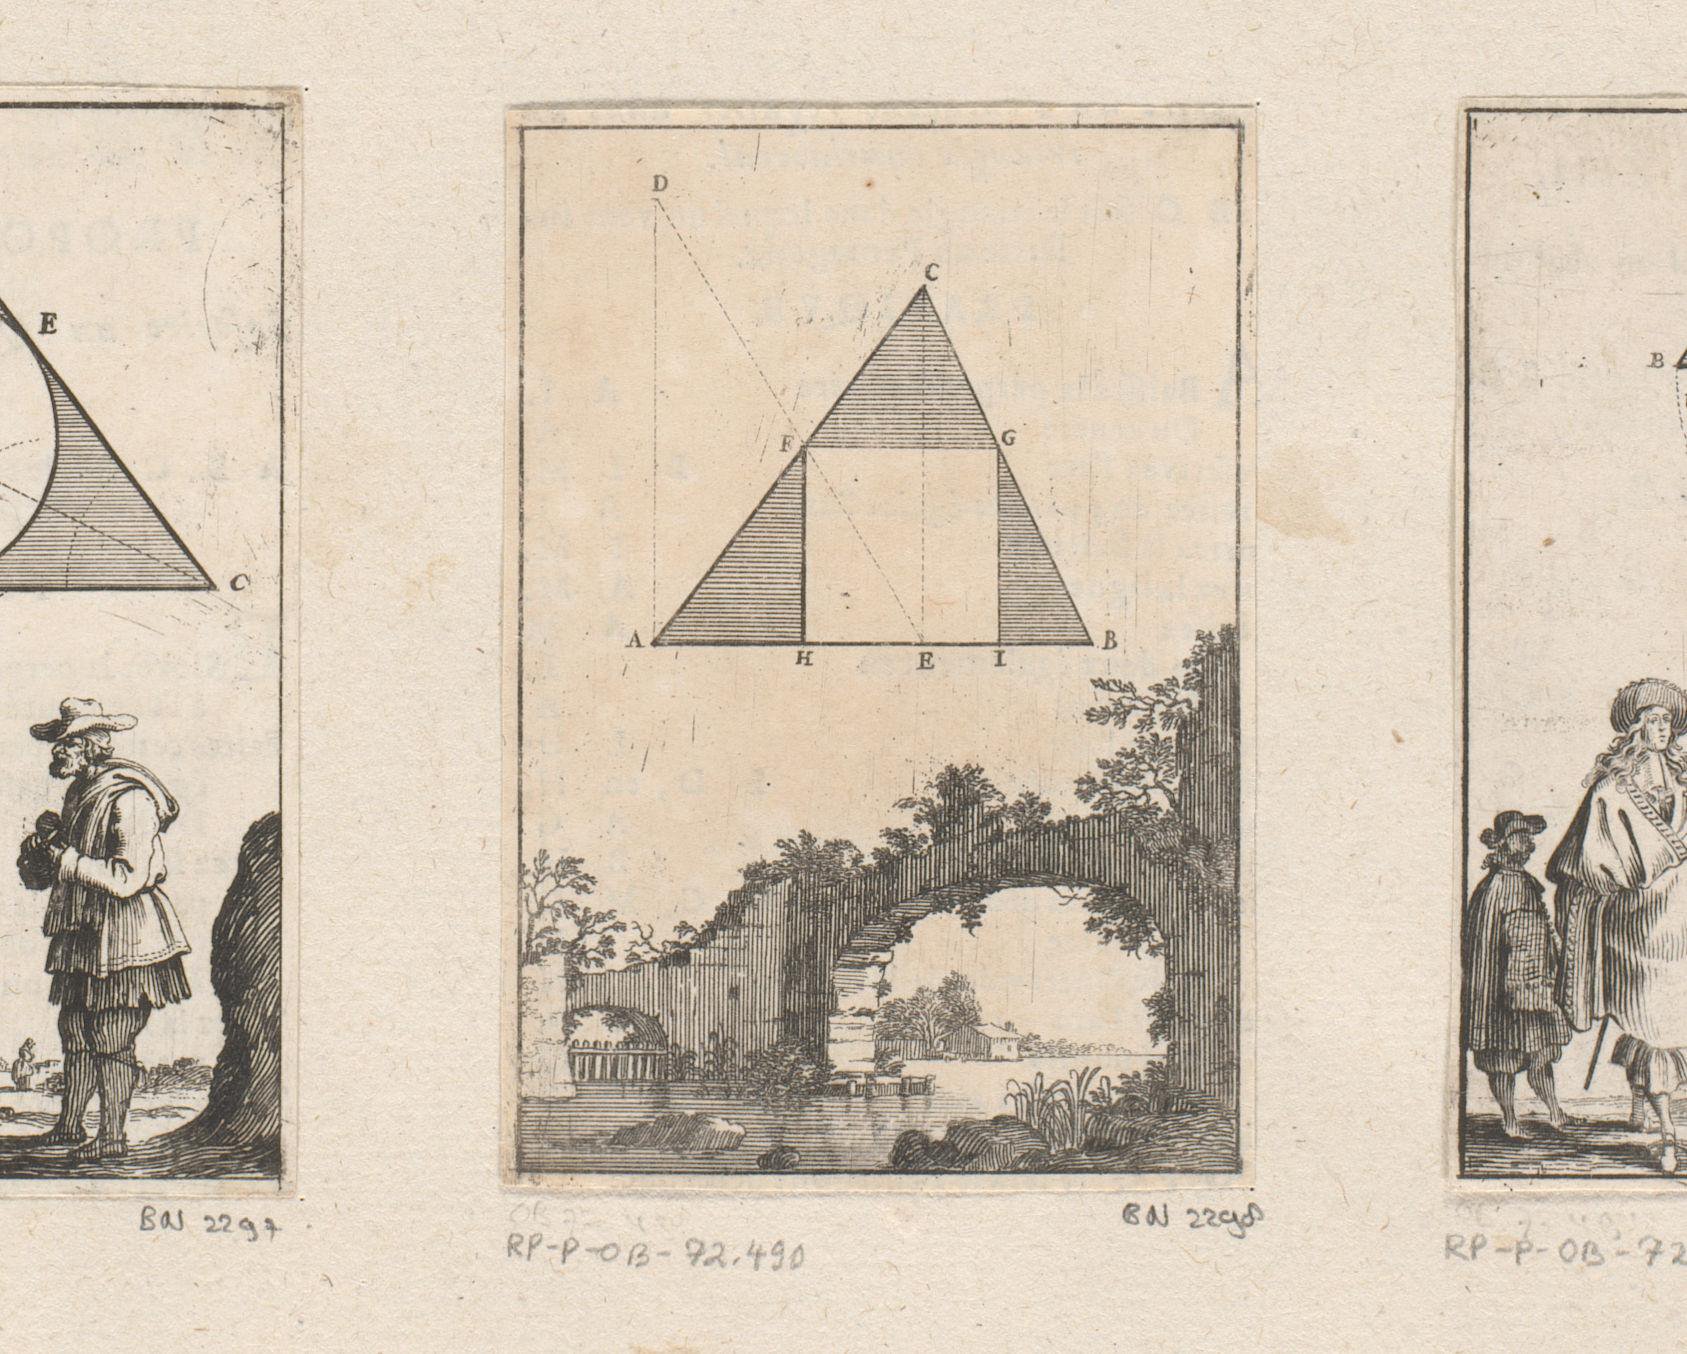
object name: book illustration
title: Constructie van een vierkant in een driehoek met onderaan een ruïne van een poort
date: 1669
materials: paper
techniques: etching, letterpress printing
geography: france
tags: regular quadrilateral: square, triangle (~ planimetry, geometry), landscape with ruins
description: Prent uit: Pratique de la géometrie, sur le papier et sur le terrain. Avec un nouvel ordre et une méthode particulière. Parijs: Thomas Jolly, 1669.